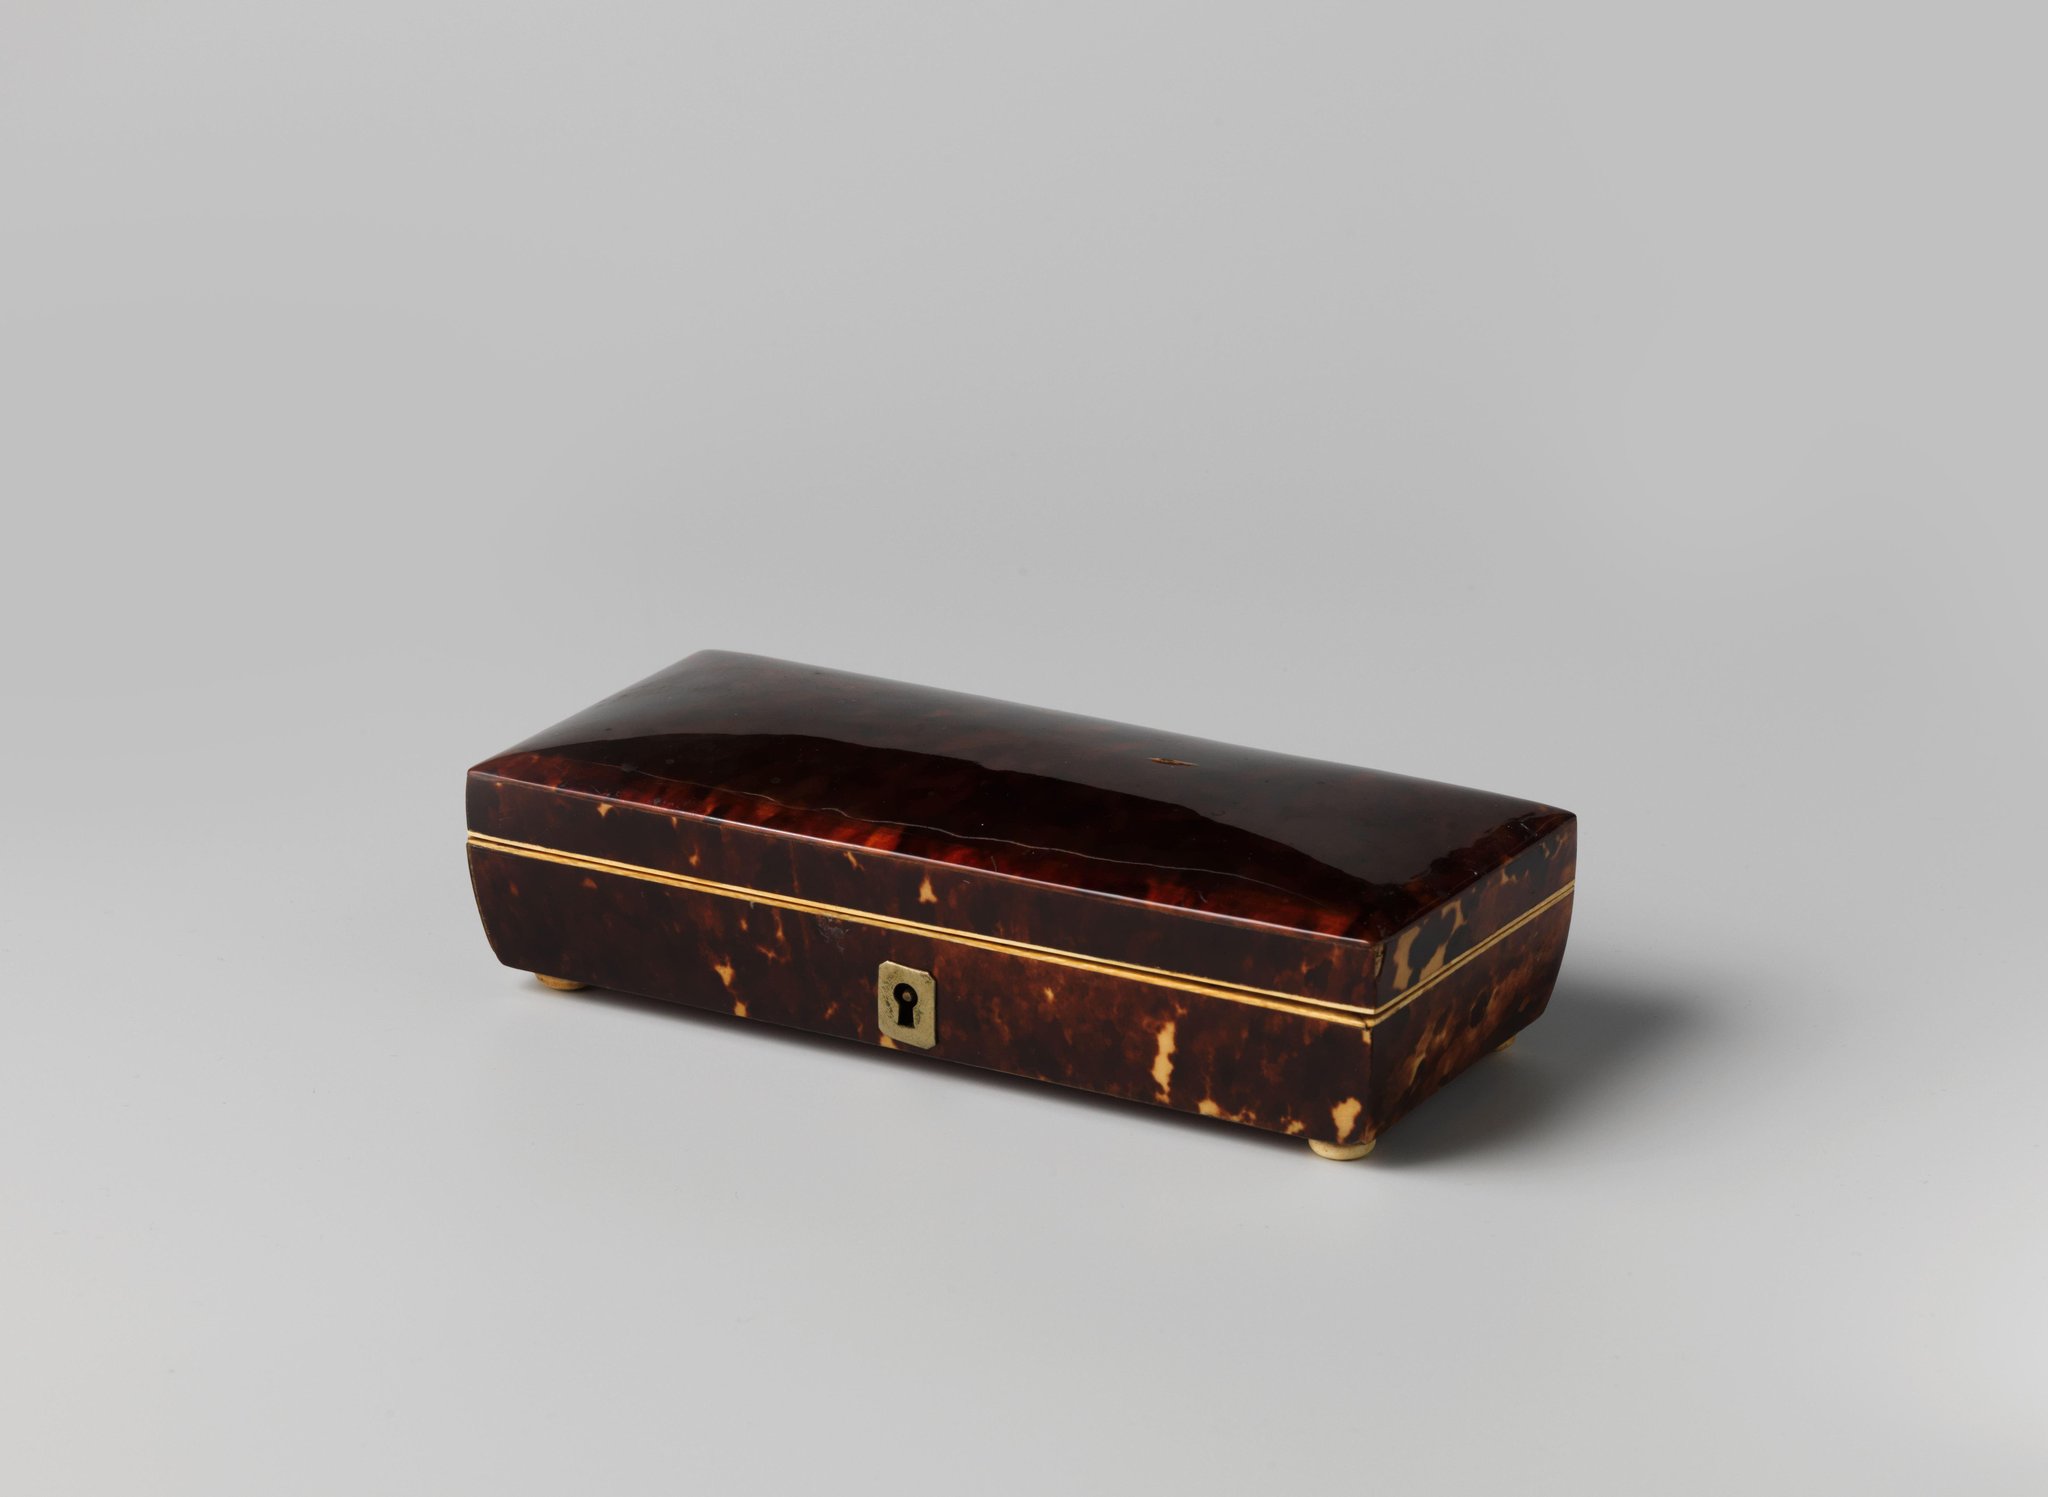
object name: lepeldoos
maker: Anonymous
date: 1800-1900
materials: shell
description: Lepeldoos van schildpad, langwerpig, gegolfde voor- en achterzijde. Enigszins bol klepdeksel. Vier ivoren bolpoten.